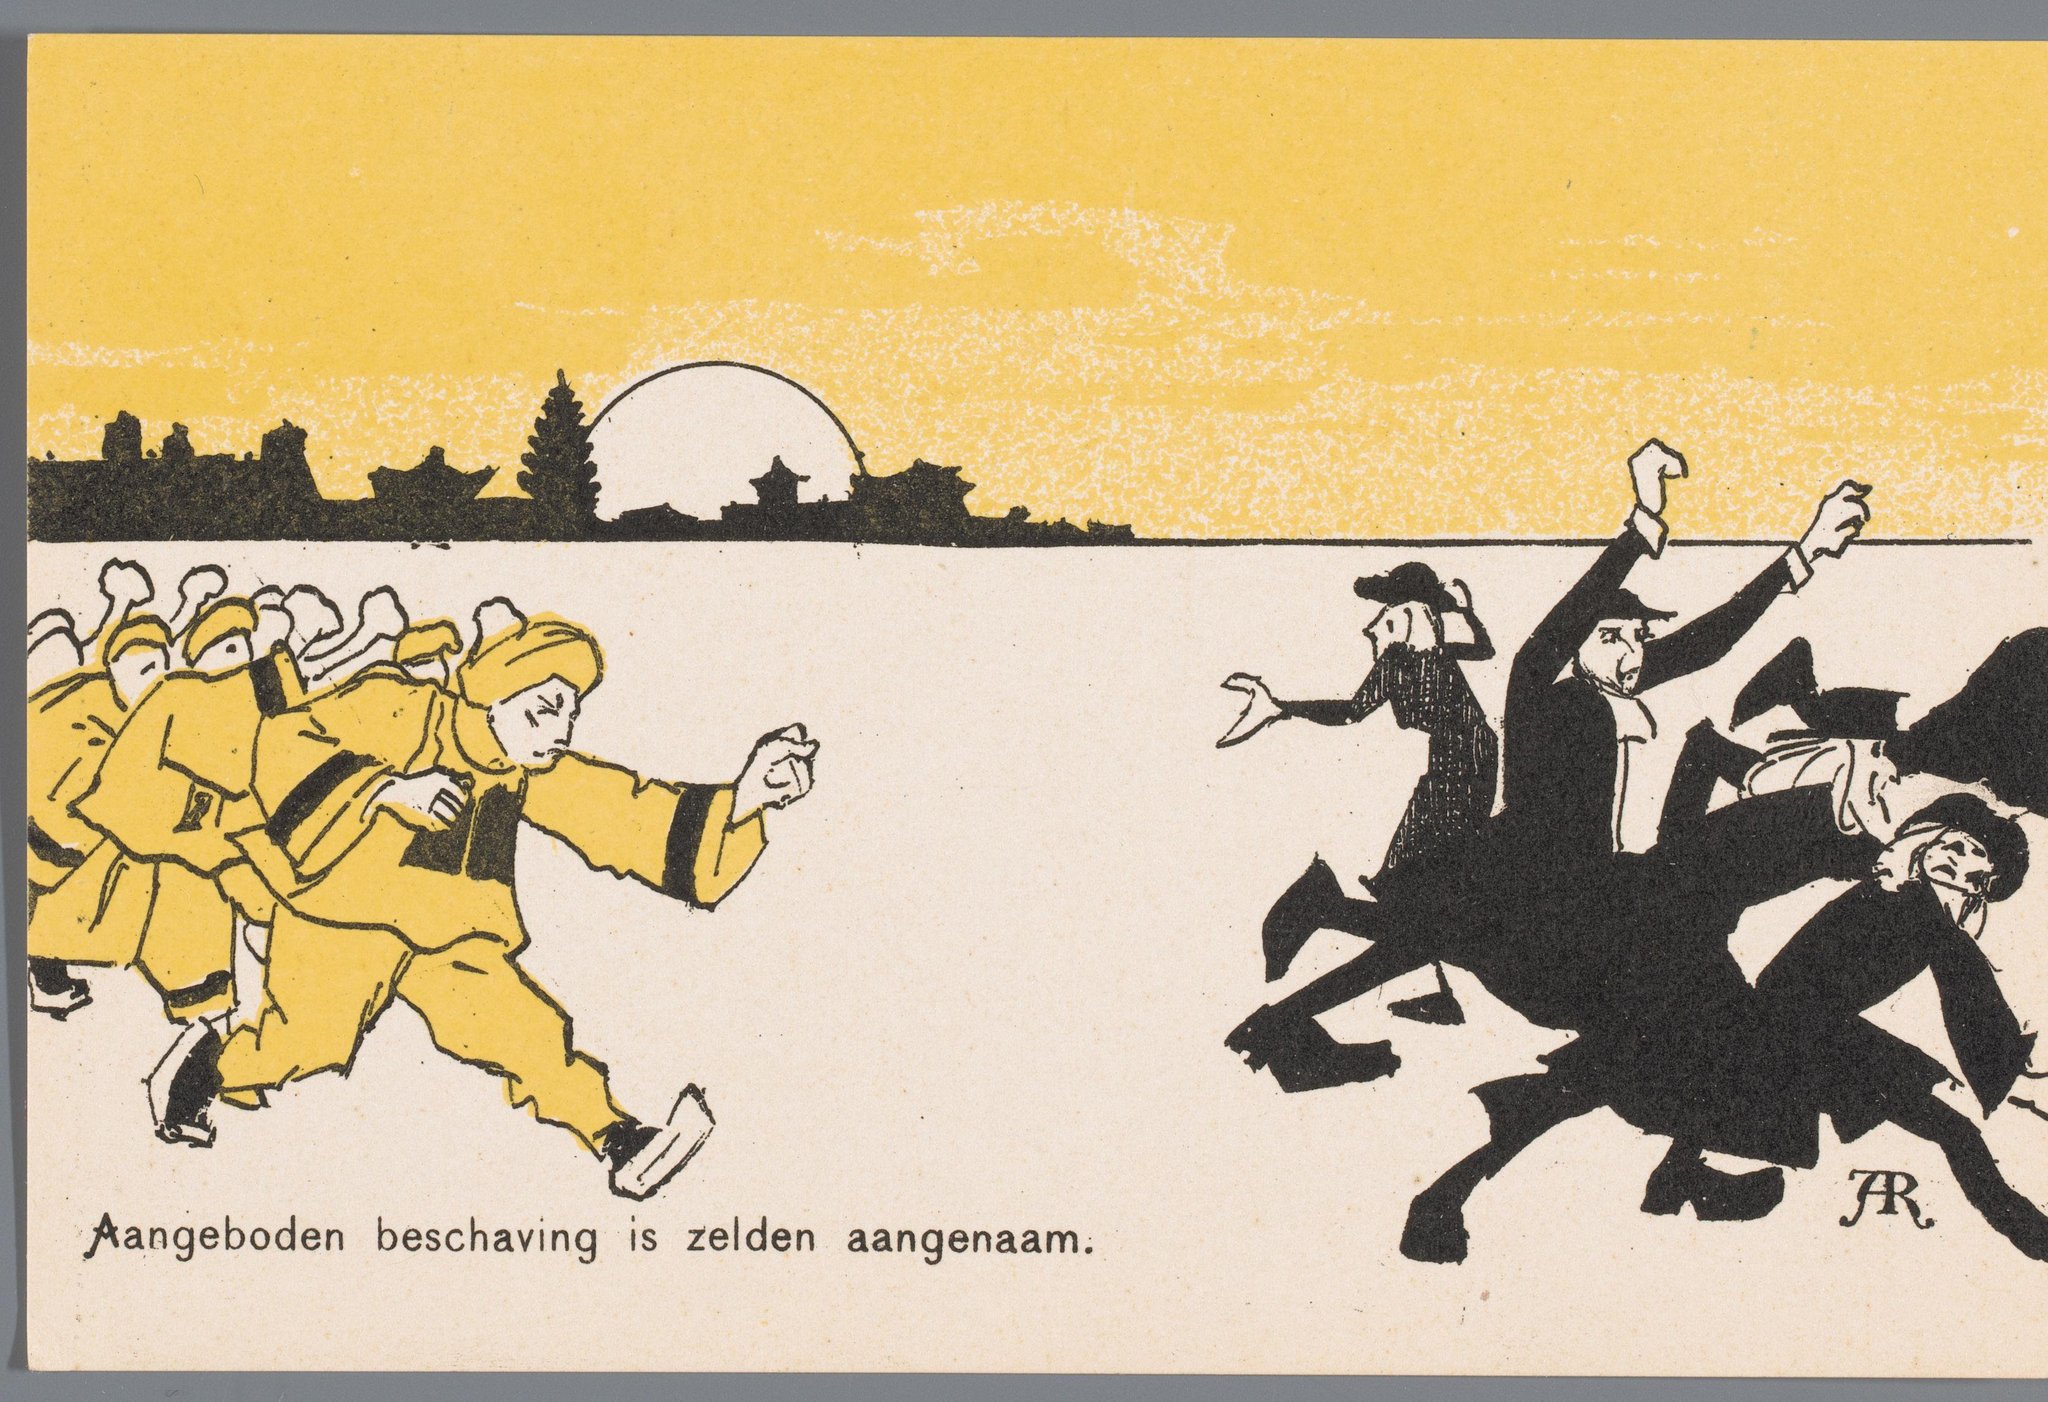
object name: ansichtkaart, prentbriefkaart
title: China prentbriefkaart 'Aangeboden beschaving is zelden aangenaam'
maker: alfaro reijding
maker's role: draughtsman, engineer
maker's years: 1863-1930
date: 1900-1918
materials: paper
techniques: printing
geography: netherlands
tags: political caricatures and satires, china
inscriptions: : ‘Aangeboden beschaving is zelden aangenaam.’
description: Prentbriefkaart in zwart en geel met een groep zwart geklede mensen die worden verdreven door Chinezen.